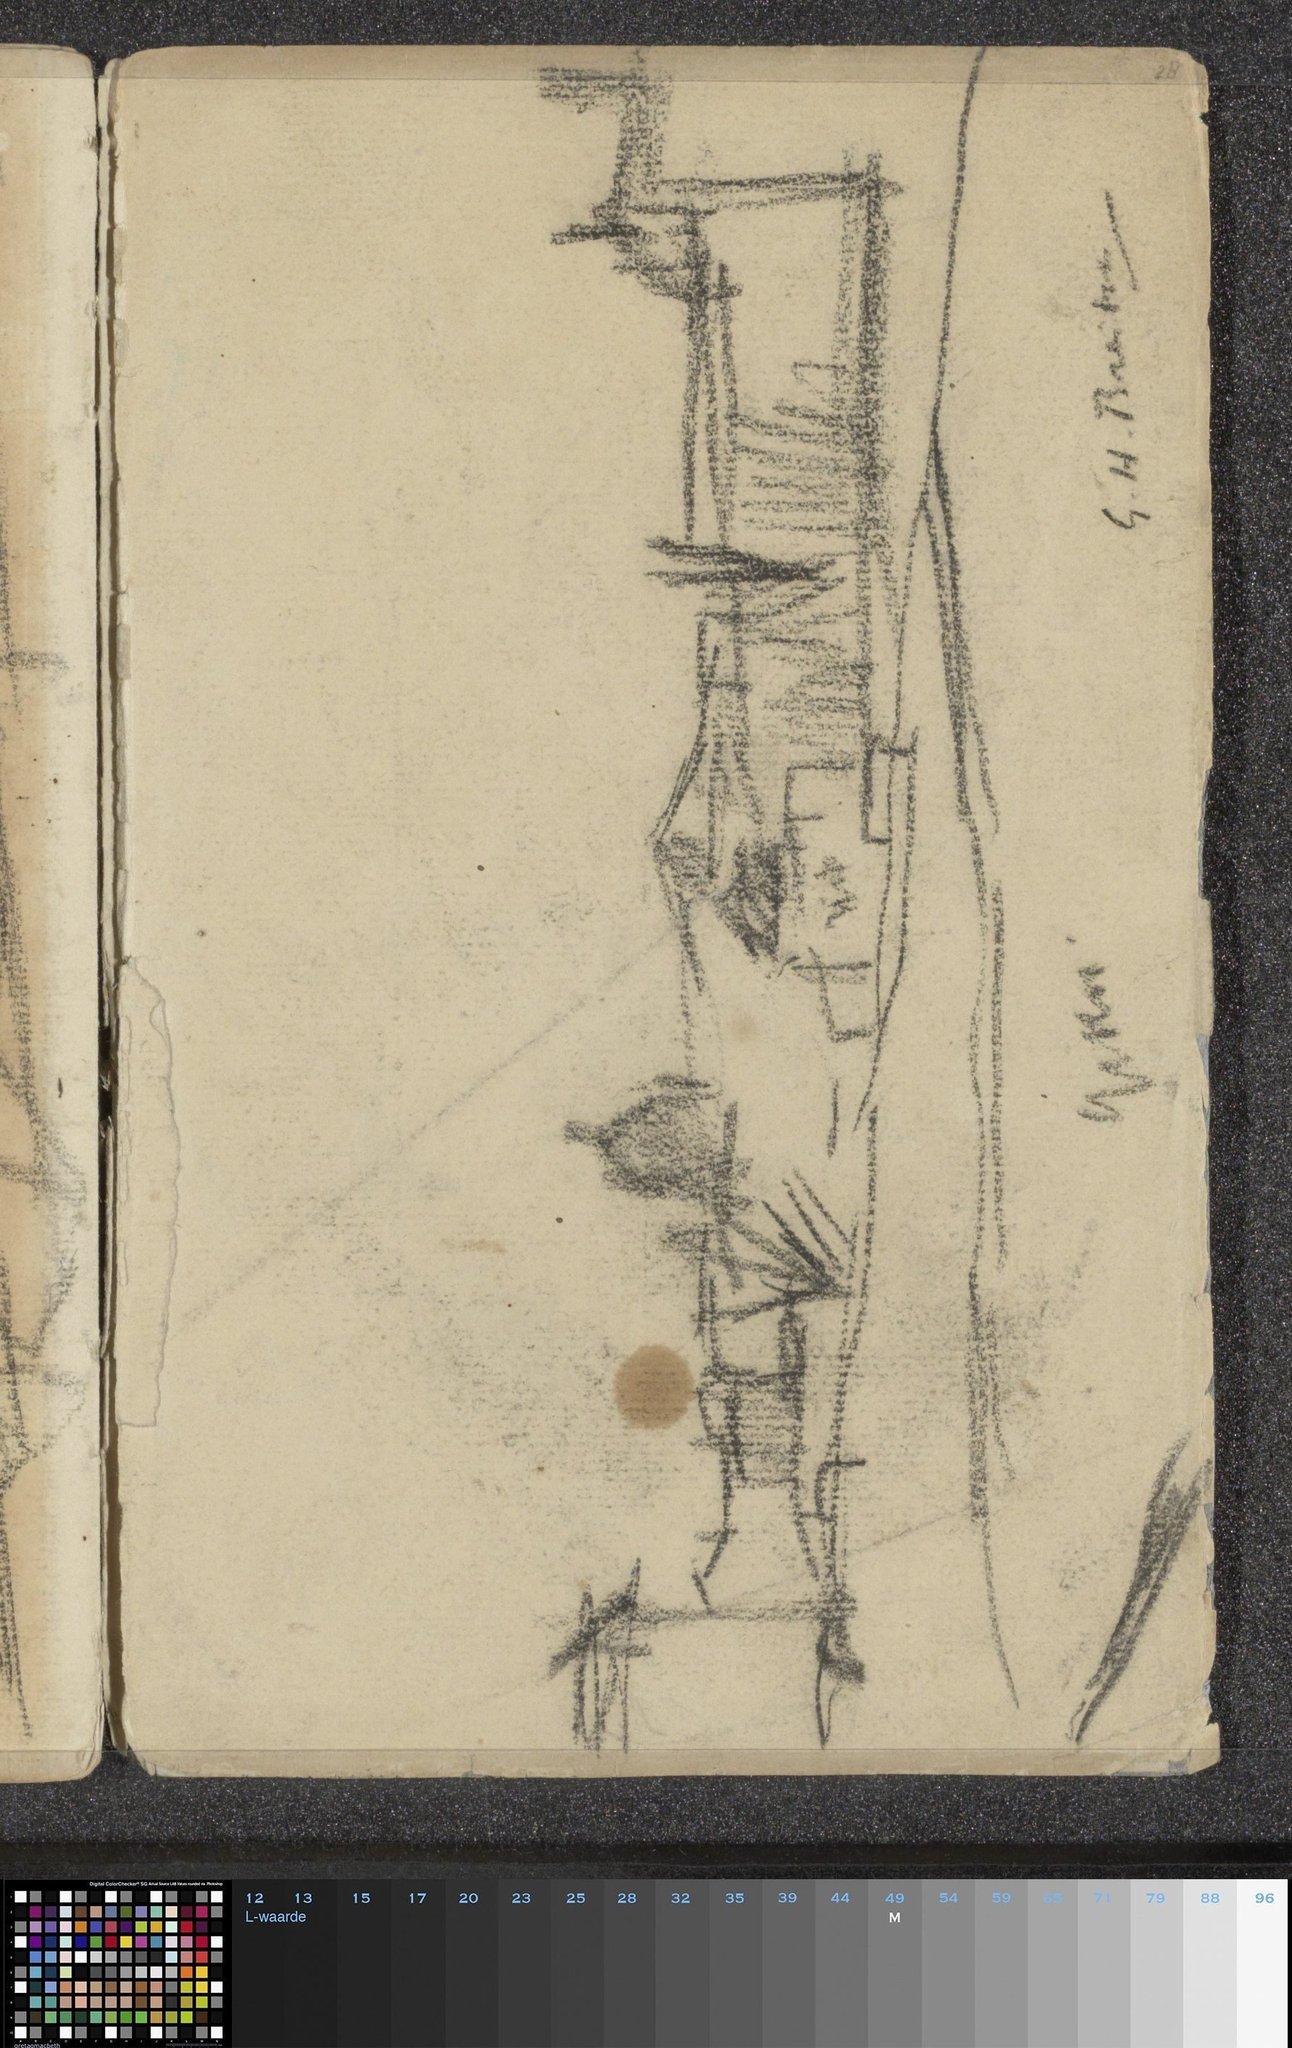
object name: sketchbook leaf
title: Stadsgezicht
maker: george hendrik breitner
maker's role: draughtsman, painter, print maker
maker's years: 1857-1923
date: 1904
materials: chalk, paper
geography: amsterdam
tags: city-view, and landscape with man-made constructions, civic architecture; edifices; dwellings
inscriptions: signature: ‘G.H. Breitner’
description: Pagina 28 uit een schetsboek met 14 bladen.